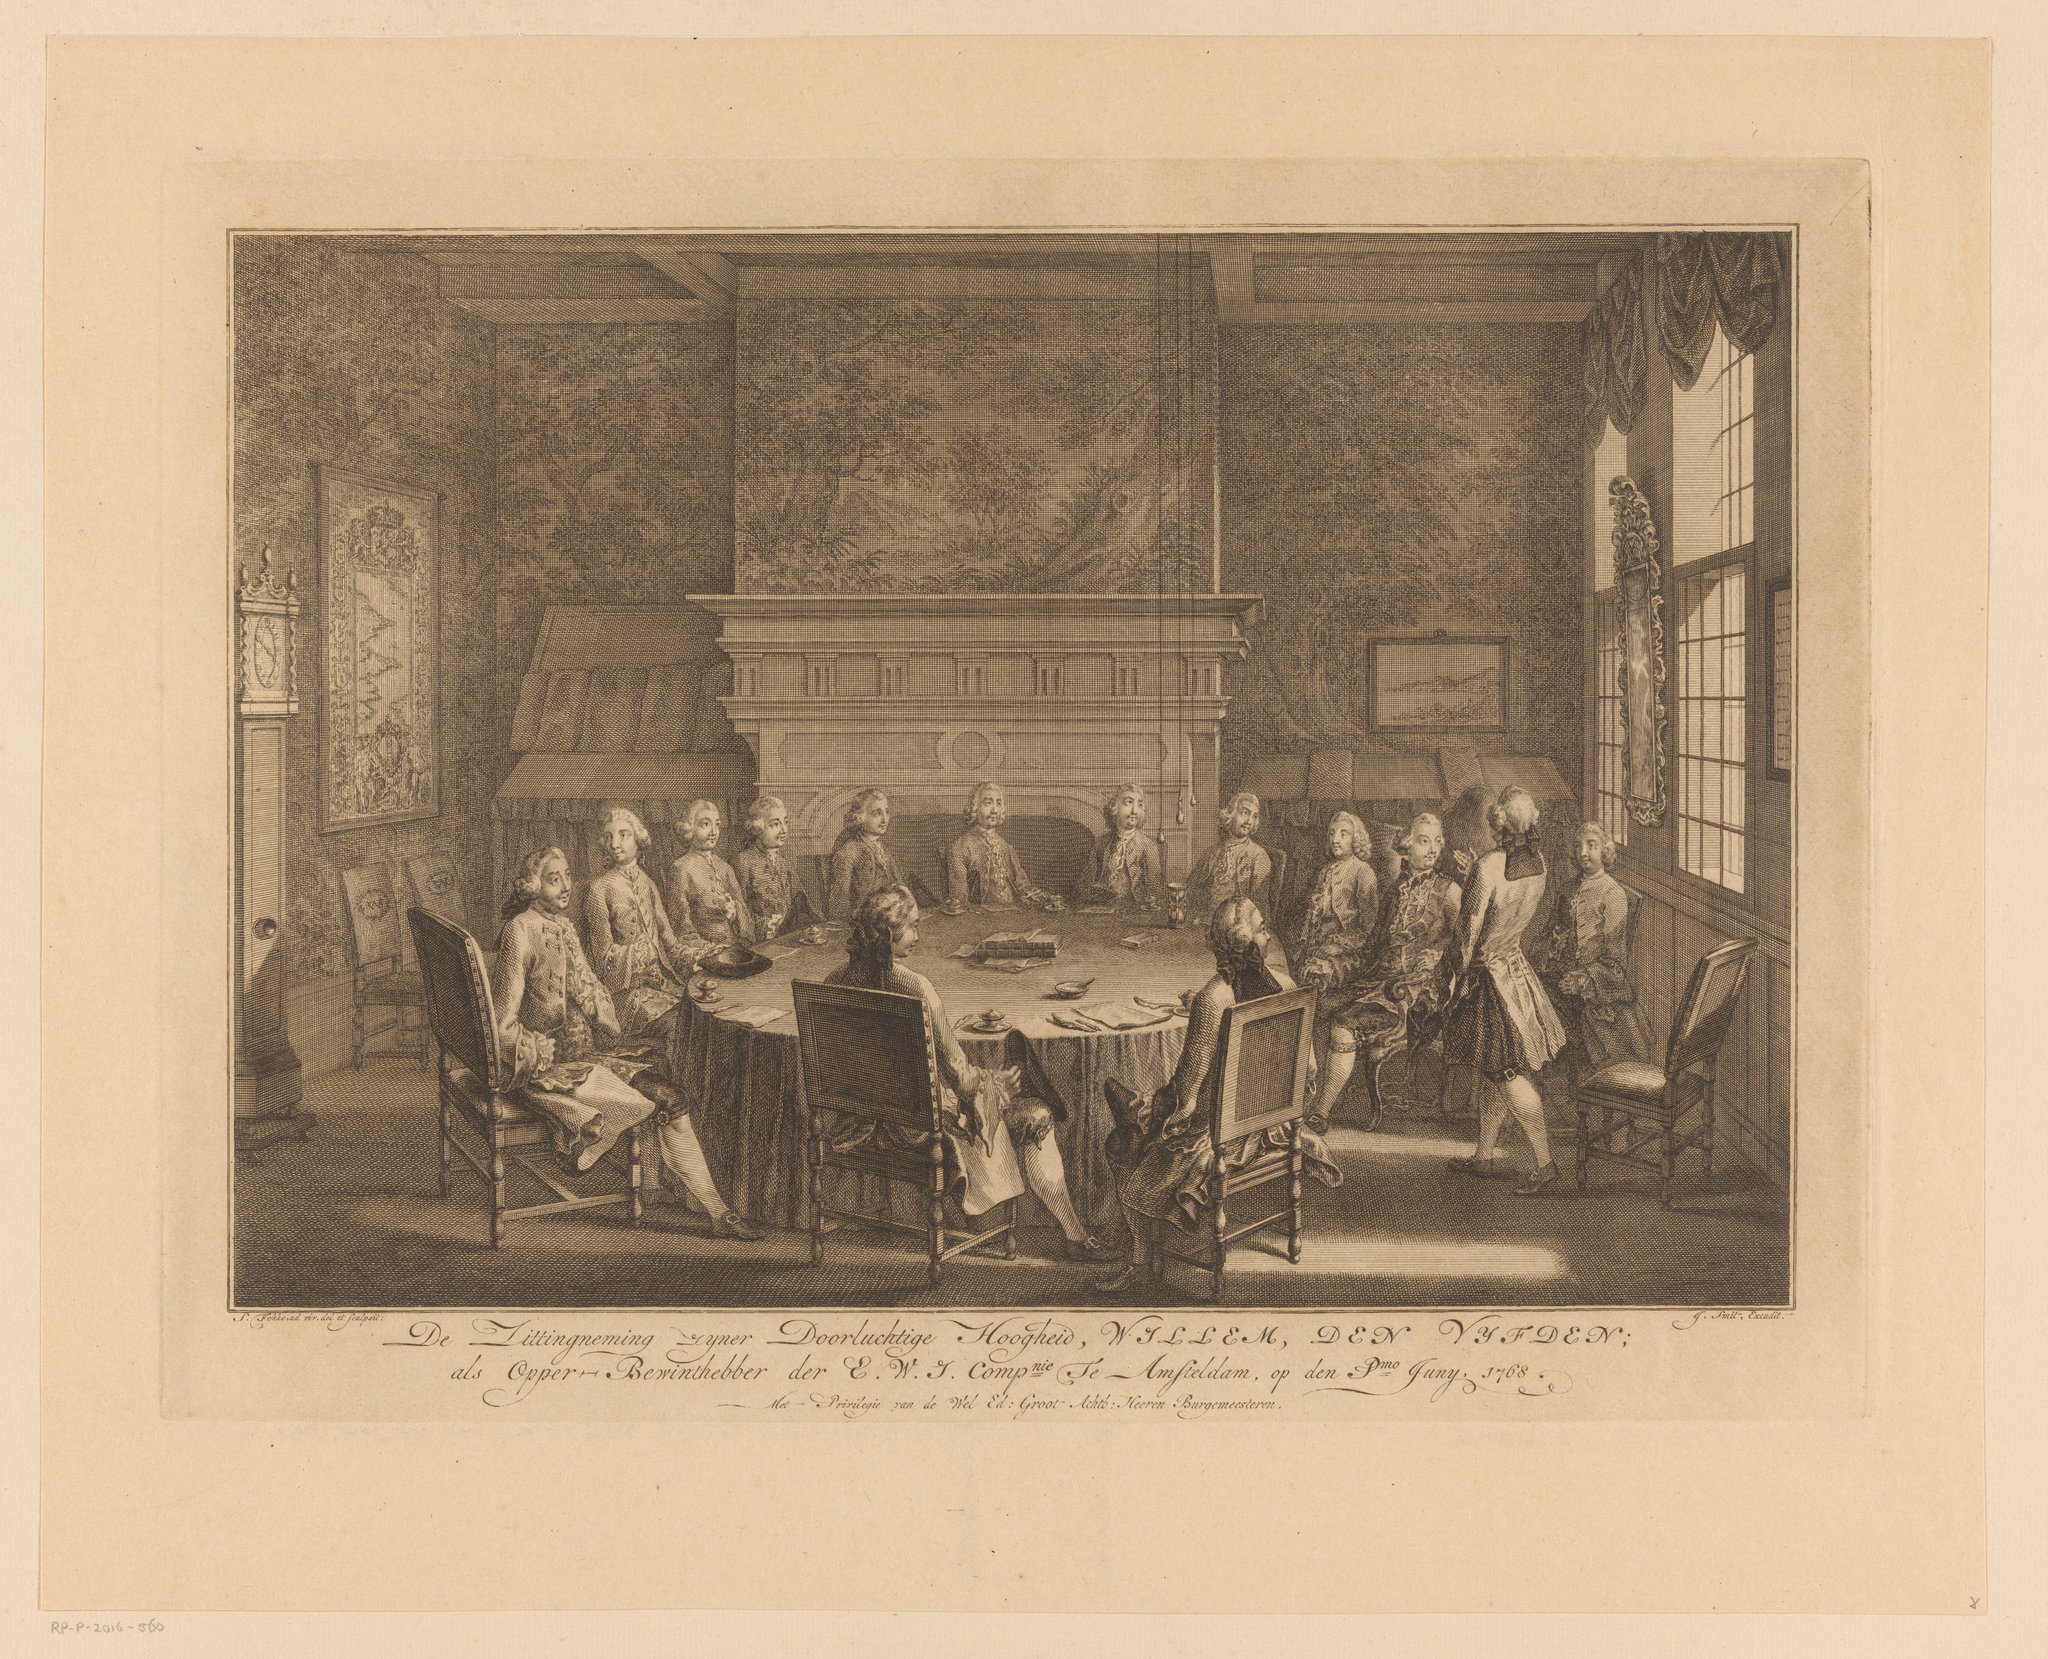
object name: print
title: De zittingneming zyner doorluchtige hoogheid, Willem, den Vyfden; als opper-bewinthebber der E.W.I. Comp(ag)nie te Amsteldam, op den p(ri)mo Juny, 1768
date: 1772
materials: paper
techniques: engraving, etching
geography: amsterdam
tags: the hague, william v (prince of orange), berlin, painter, wilhelmina of prussia (princess of orange), meeting, assembly, amsterdam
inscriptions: collector's mark: Lugt 2228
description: Stadhouder Willem V neemt als opperbewindhebber zitting tussen de directeuren van de WIC te Amsterdam, 1 juni 1768.